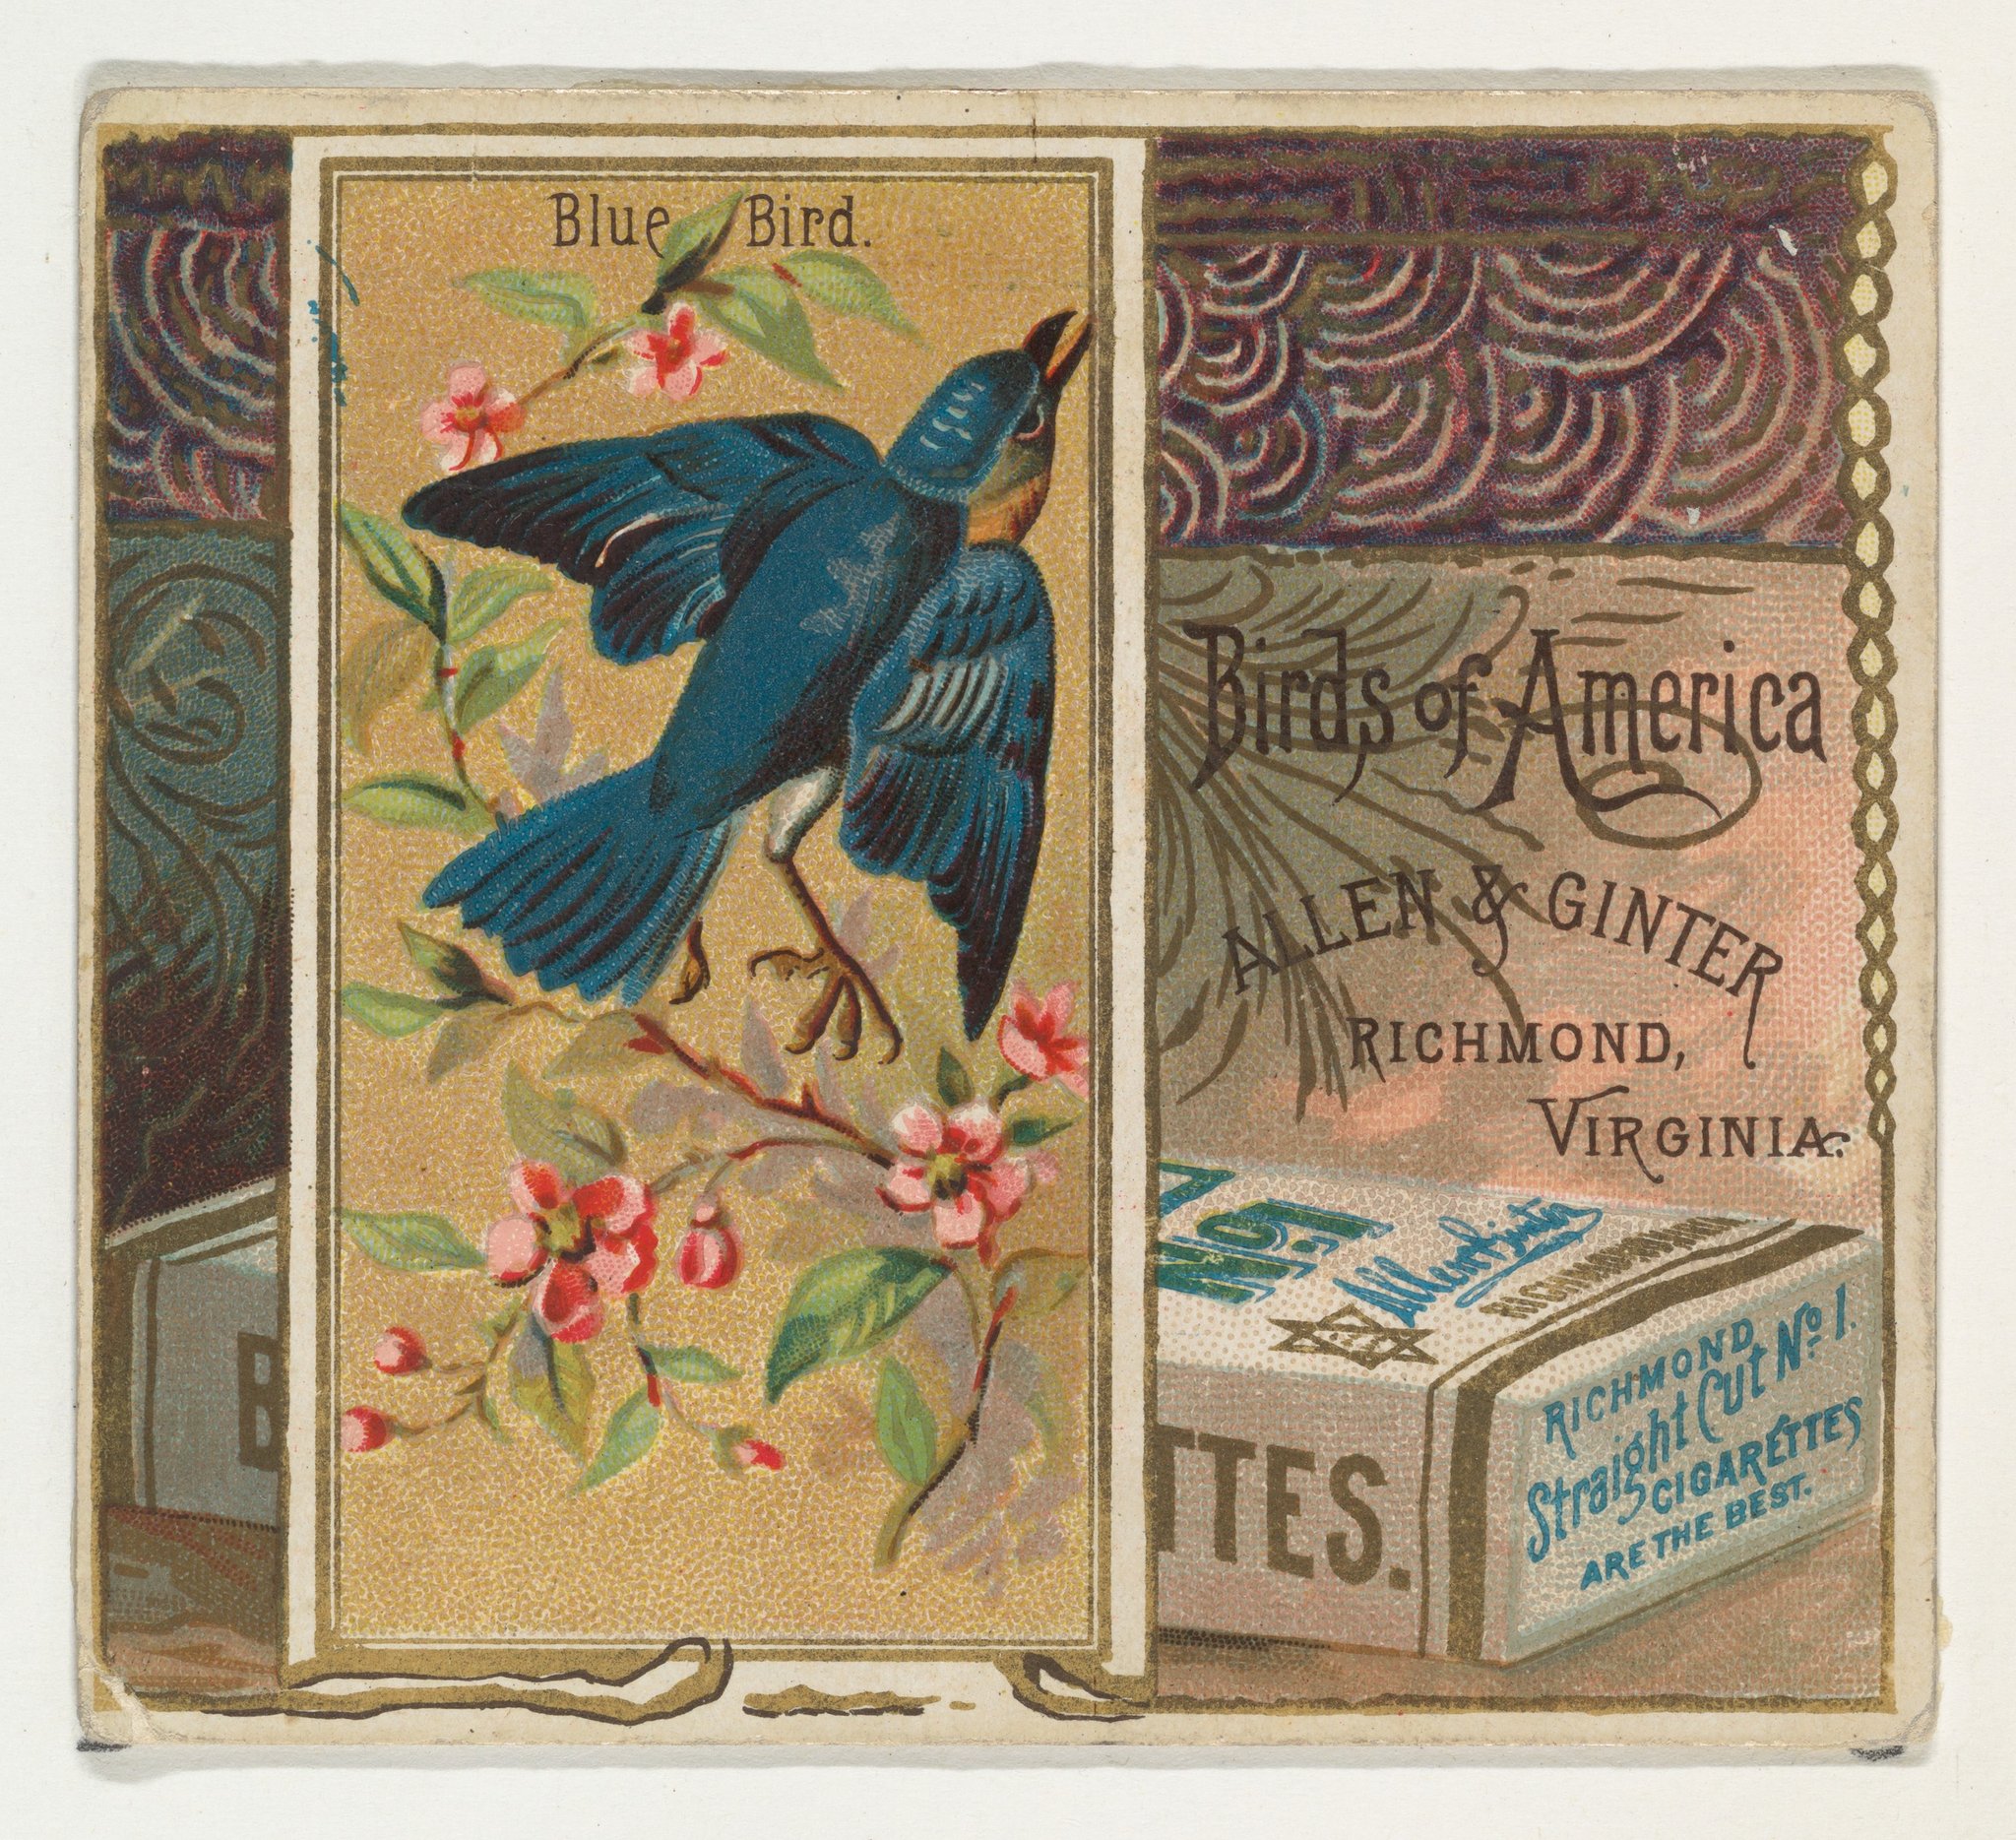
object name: print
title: Bluebird, from the Birds of America series (N37) for Allen & Ginter Cigarettes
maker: allen & ginter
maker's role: publisher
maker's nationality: american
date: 1888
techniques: color lithograph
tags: birds